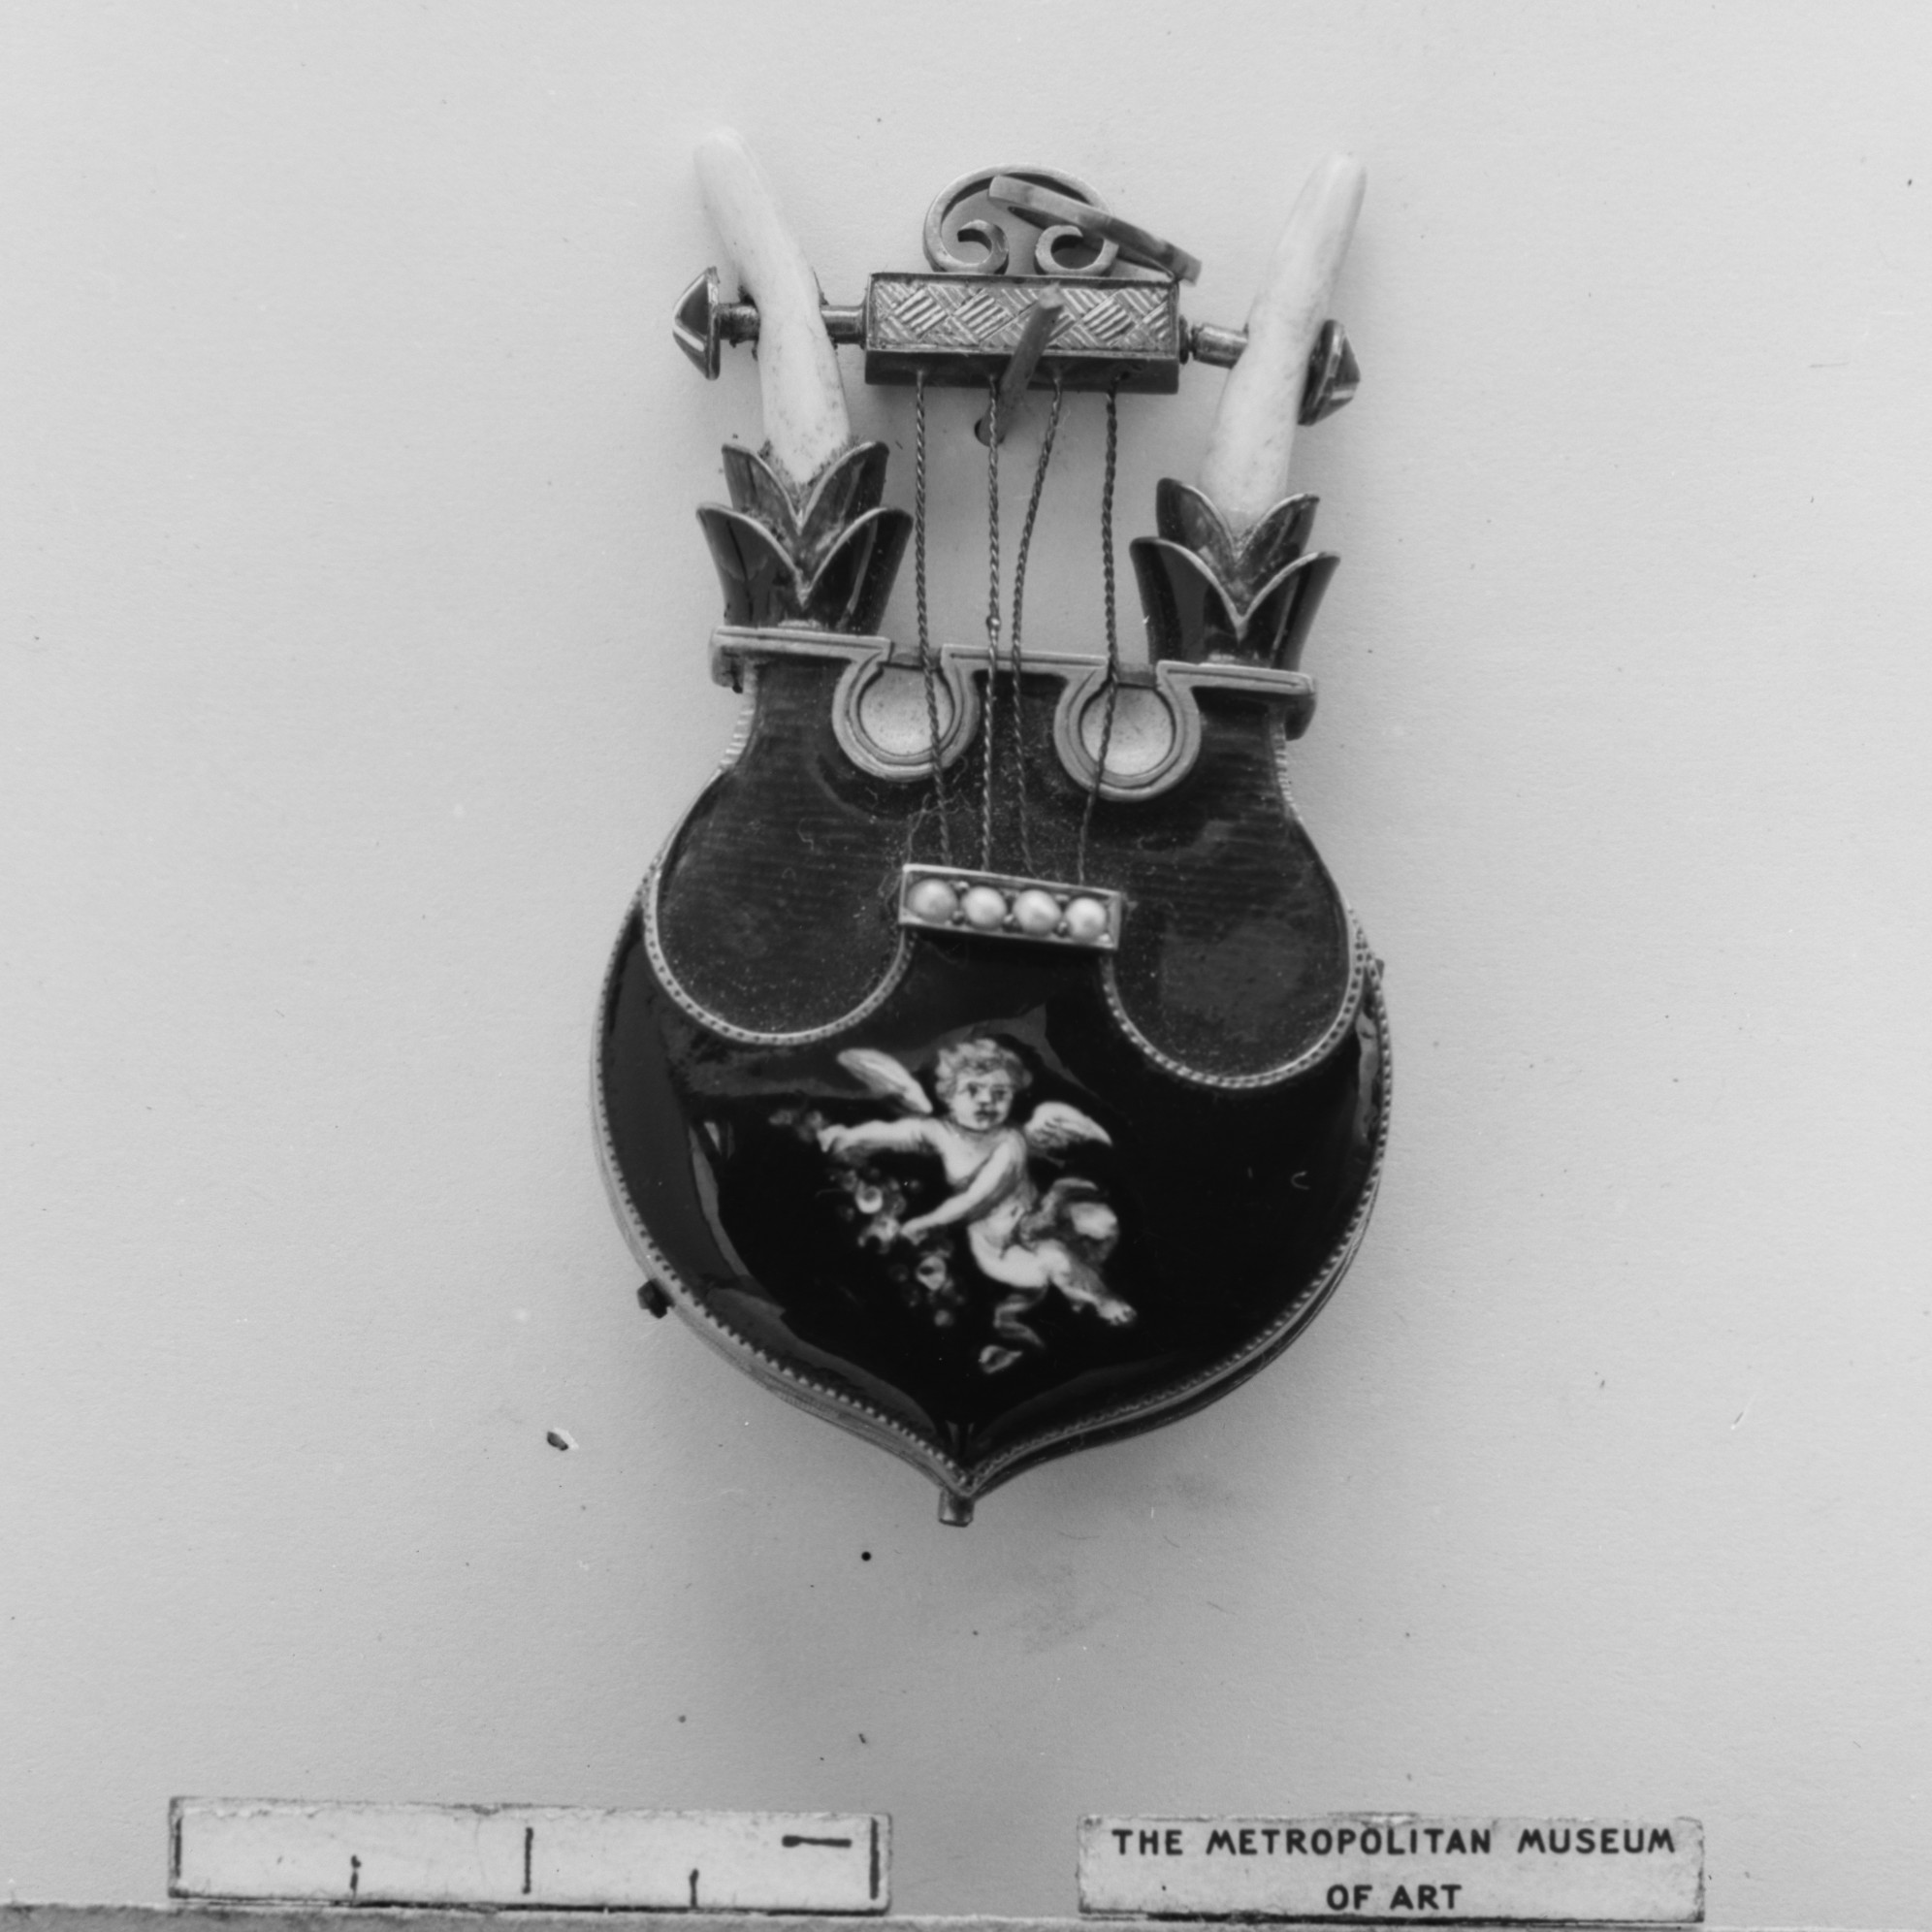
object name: watch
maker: michael ranna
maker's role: maker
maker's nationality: austrian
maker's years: 1800-1900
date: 1801-1900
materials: gold, ivory, metal, pearl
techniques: enamel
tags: putti,lyres